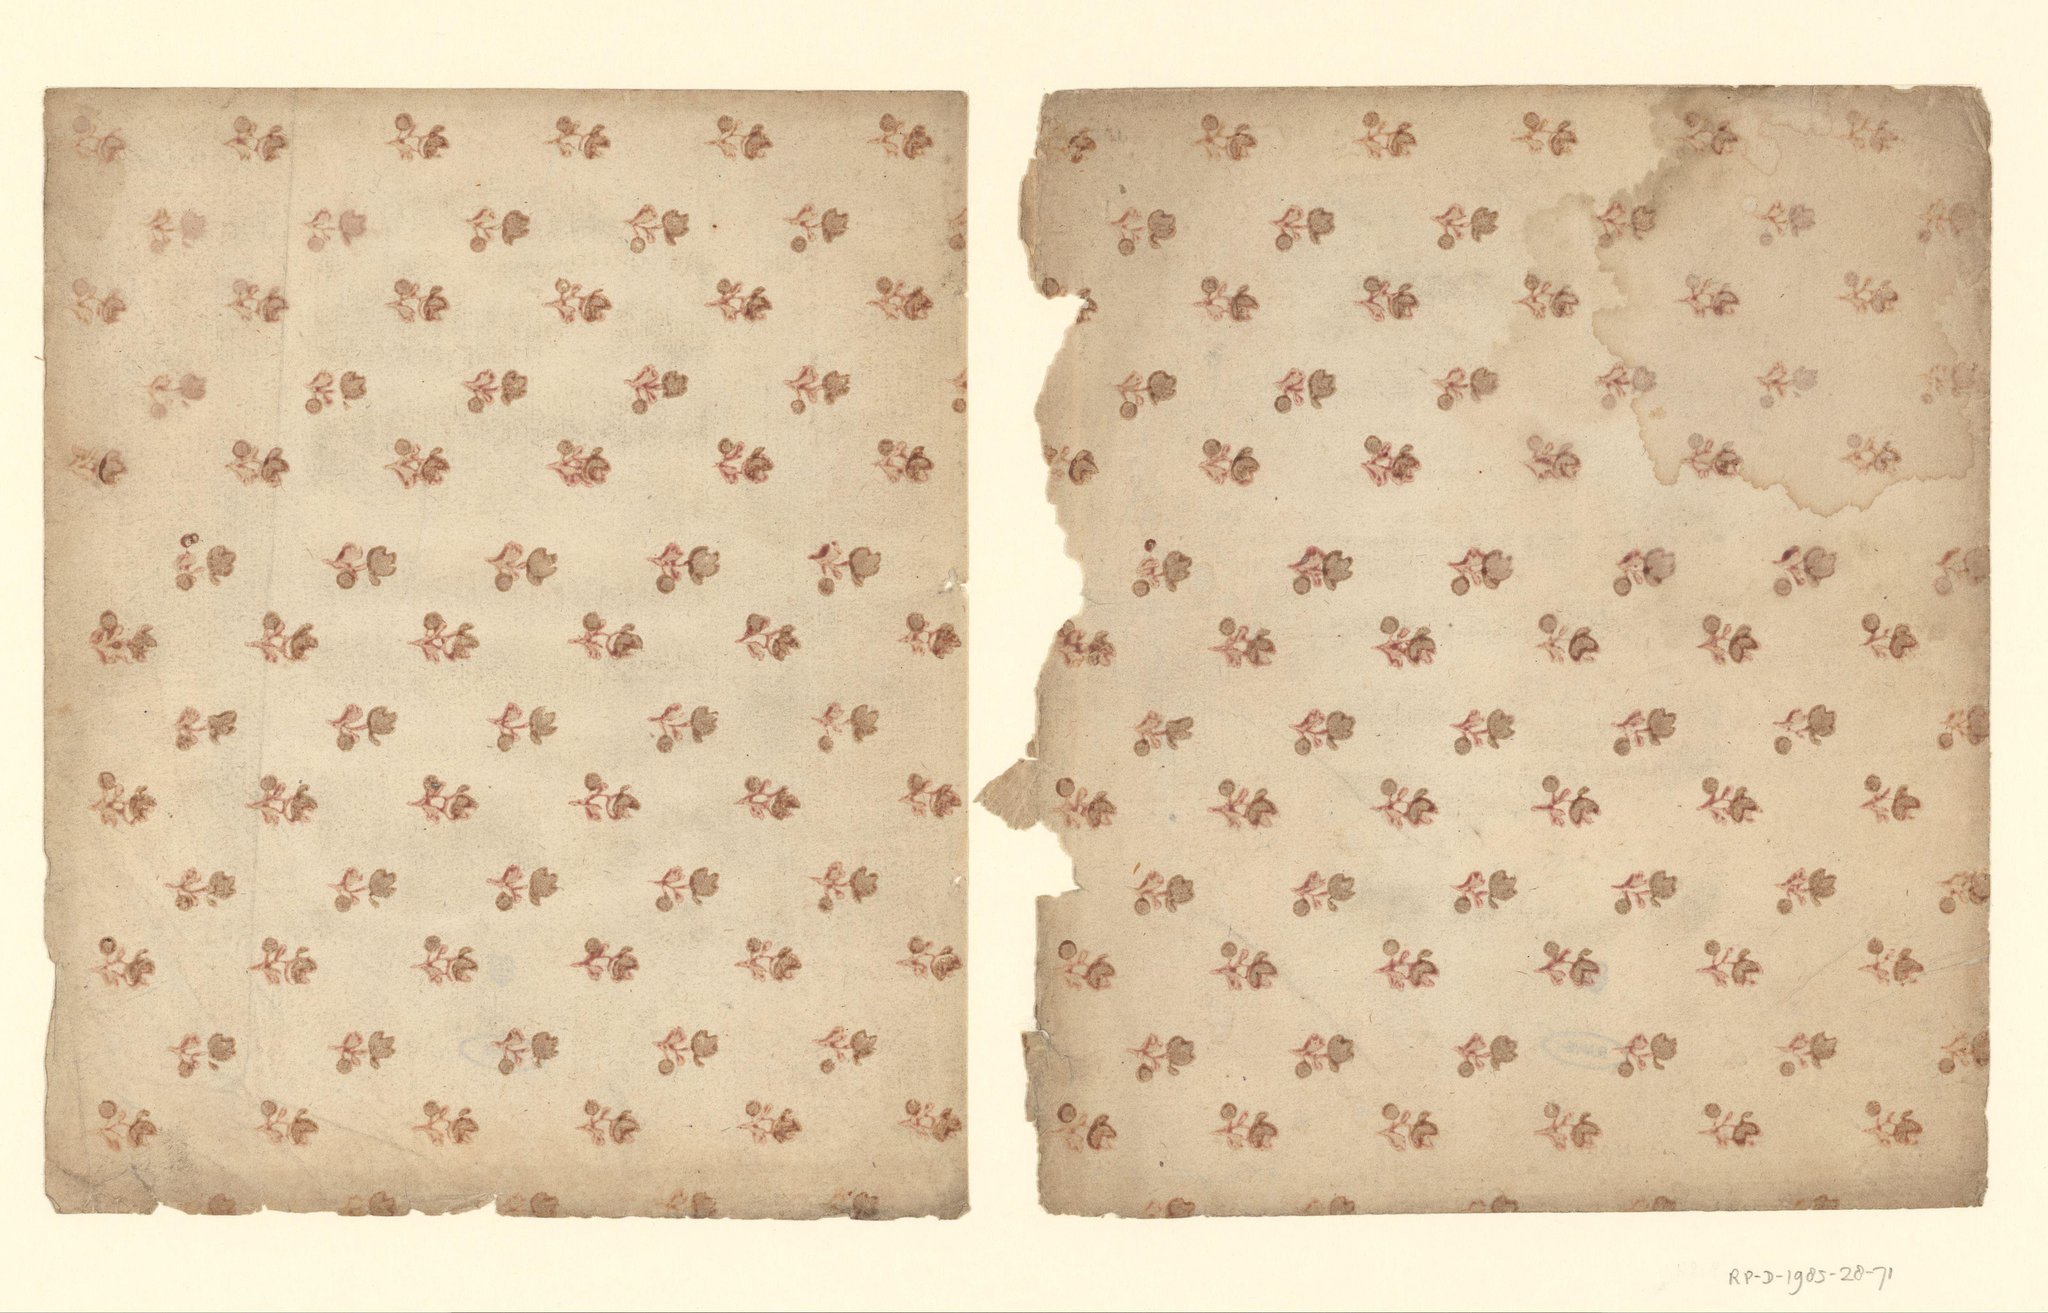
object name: wrapper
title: Twee bladen met strooipatroon van bloemtakje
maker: Anonymous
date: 1750-1900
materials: paper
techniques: printing block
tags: ornament derived from plant forms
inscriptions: collector's mark: Lugt 2760, collector's mark: Lugt 2228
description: Twee bladen met strooipatroon van bloemtakje. Twee losse helften van een omslag.